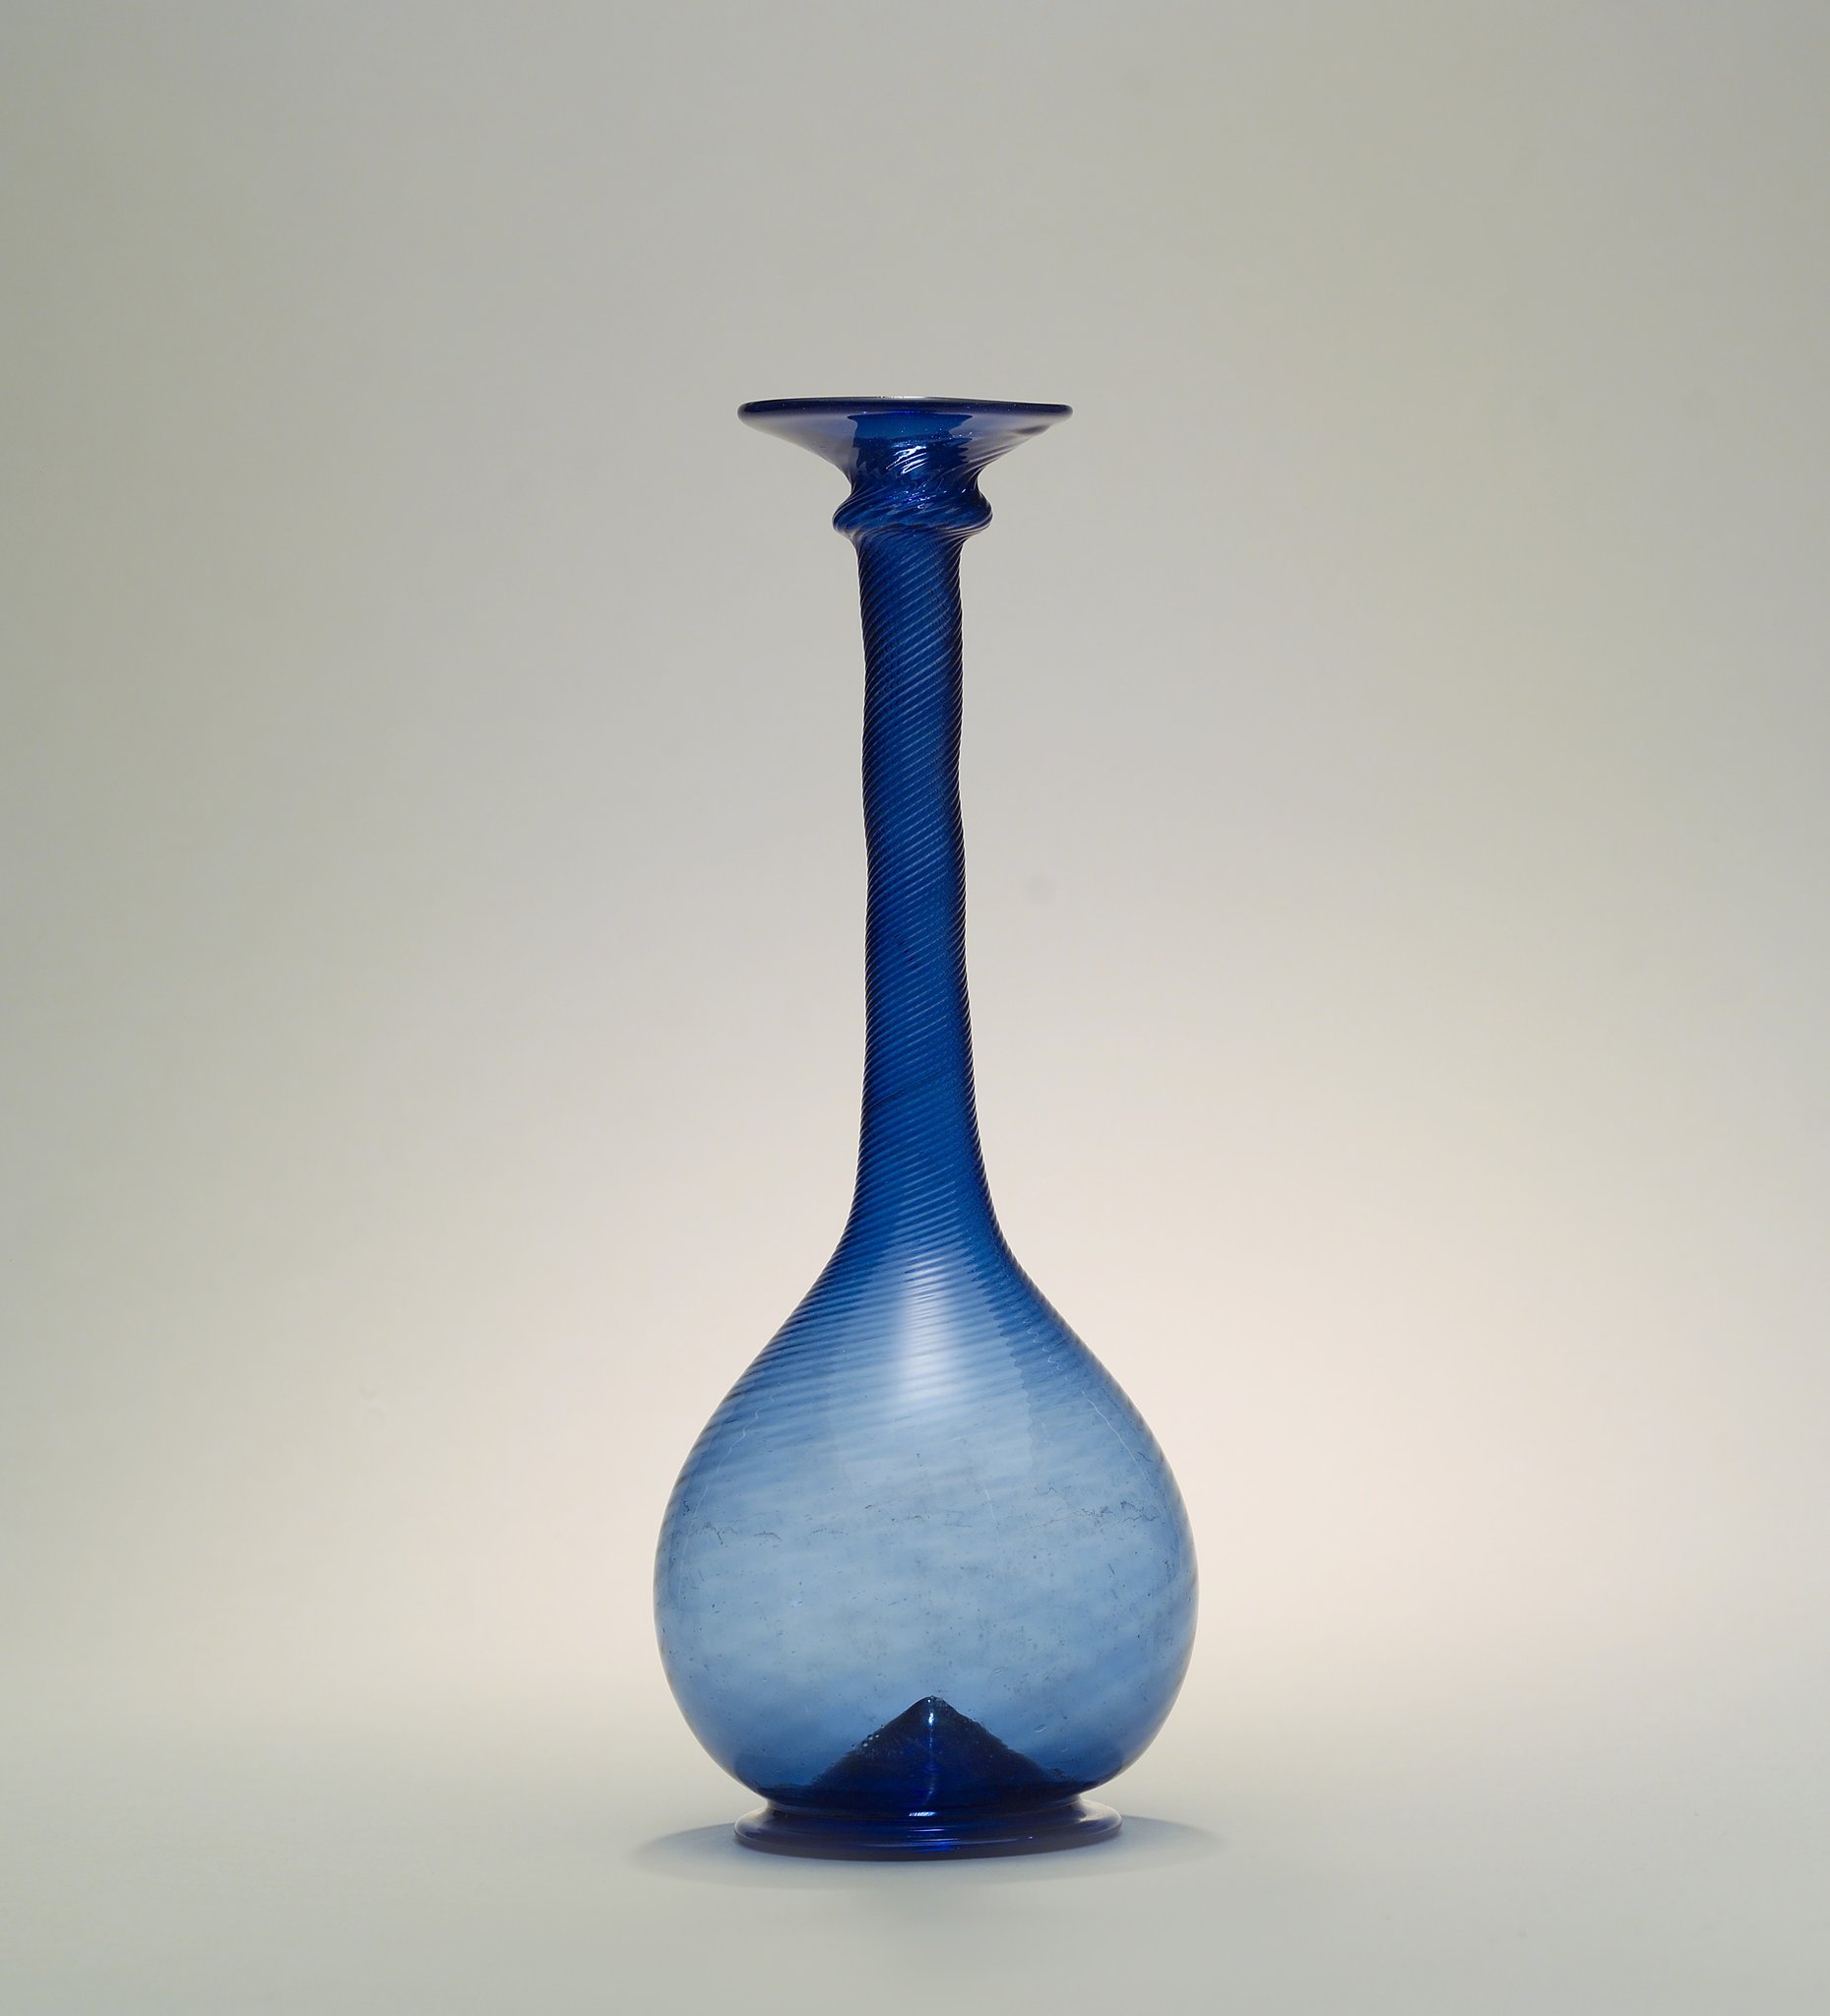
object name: bottle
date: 1701-1900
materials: glass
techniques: molding, tooling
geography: iran